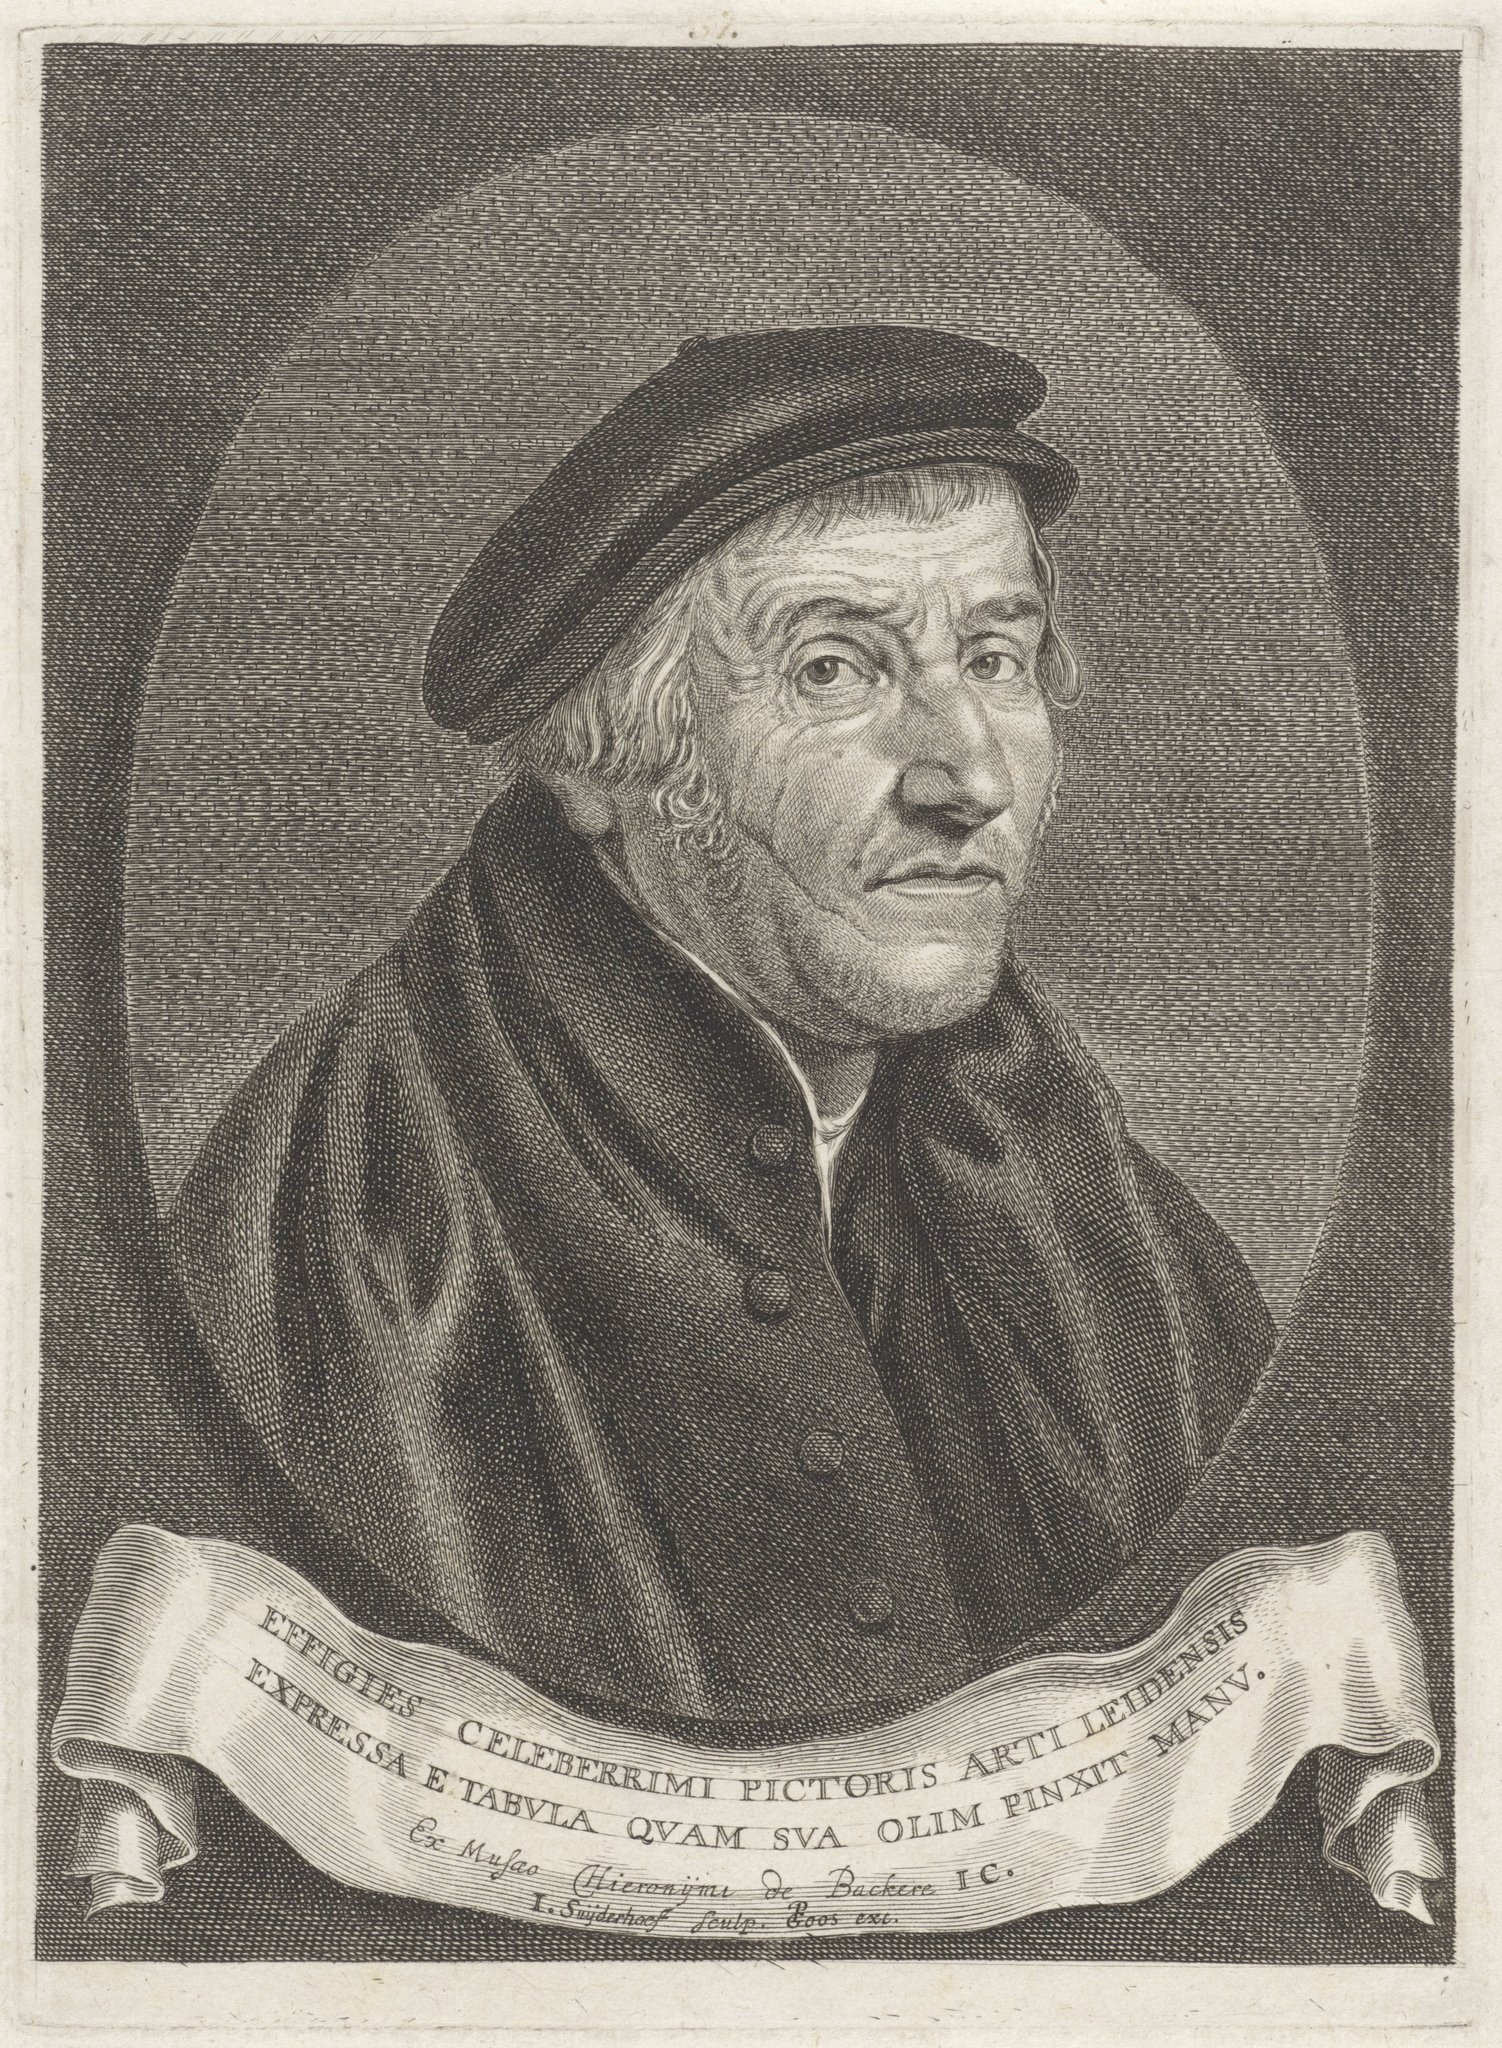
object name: print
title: Portret van Aertgen Claesz. van Leyden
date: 1657-1675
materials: paper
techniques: engraving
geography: amsterdam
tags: leiden, painter, draughtsman, aertgen claesz van leyden, portrait, self-portrait of painter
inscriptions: caption: ‘EFFIGIES CELEBERRIMI PICTORIS ARTI LEIDENSIS EXPRESSA E TABULA QUAM SUA OLIM PINXIT MANU.’, signature: ‘Ex Musao Hieronijmi de Backere IC. I. Suyderhoef sculp. P Goos exc.’, collector's mark: Lugt 2228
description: Portret van de schilder Aertgen Claesz. van Leyden. Hij heeft een litteken op de rechterwang. Onder het portret een banderol met een tweeregelige tekst in het Latijn.